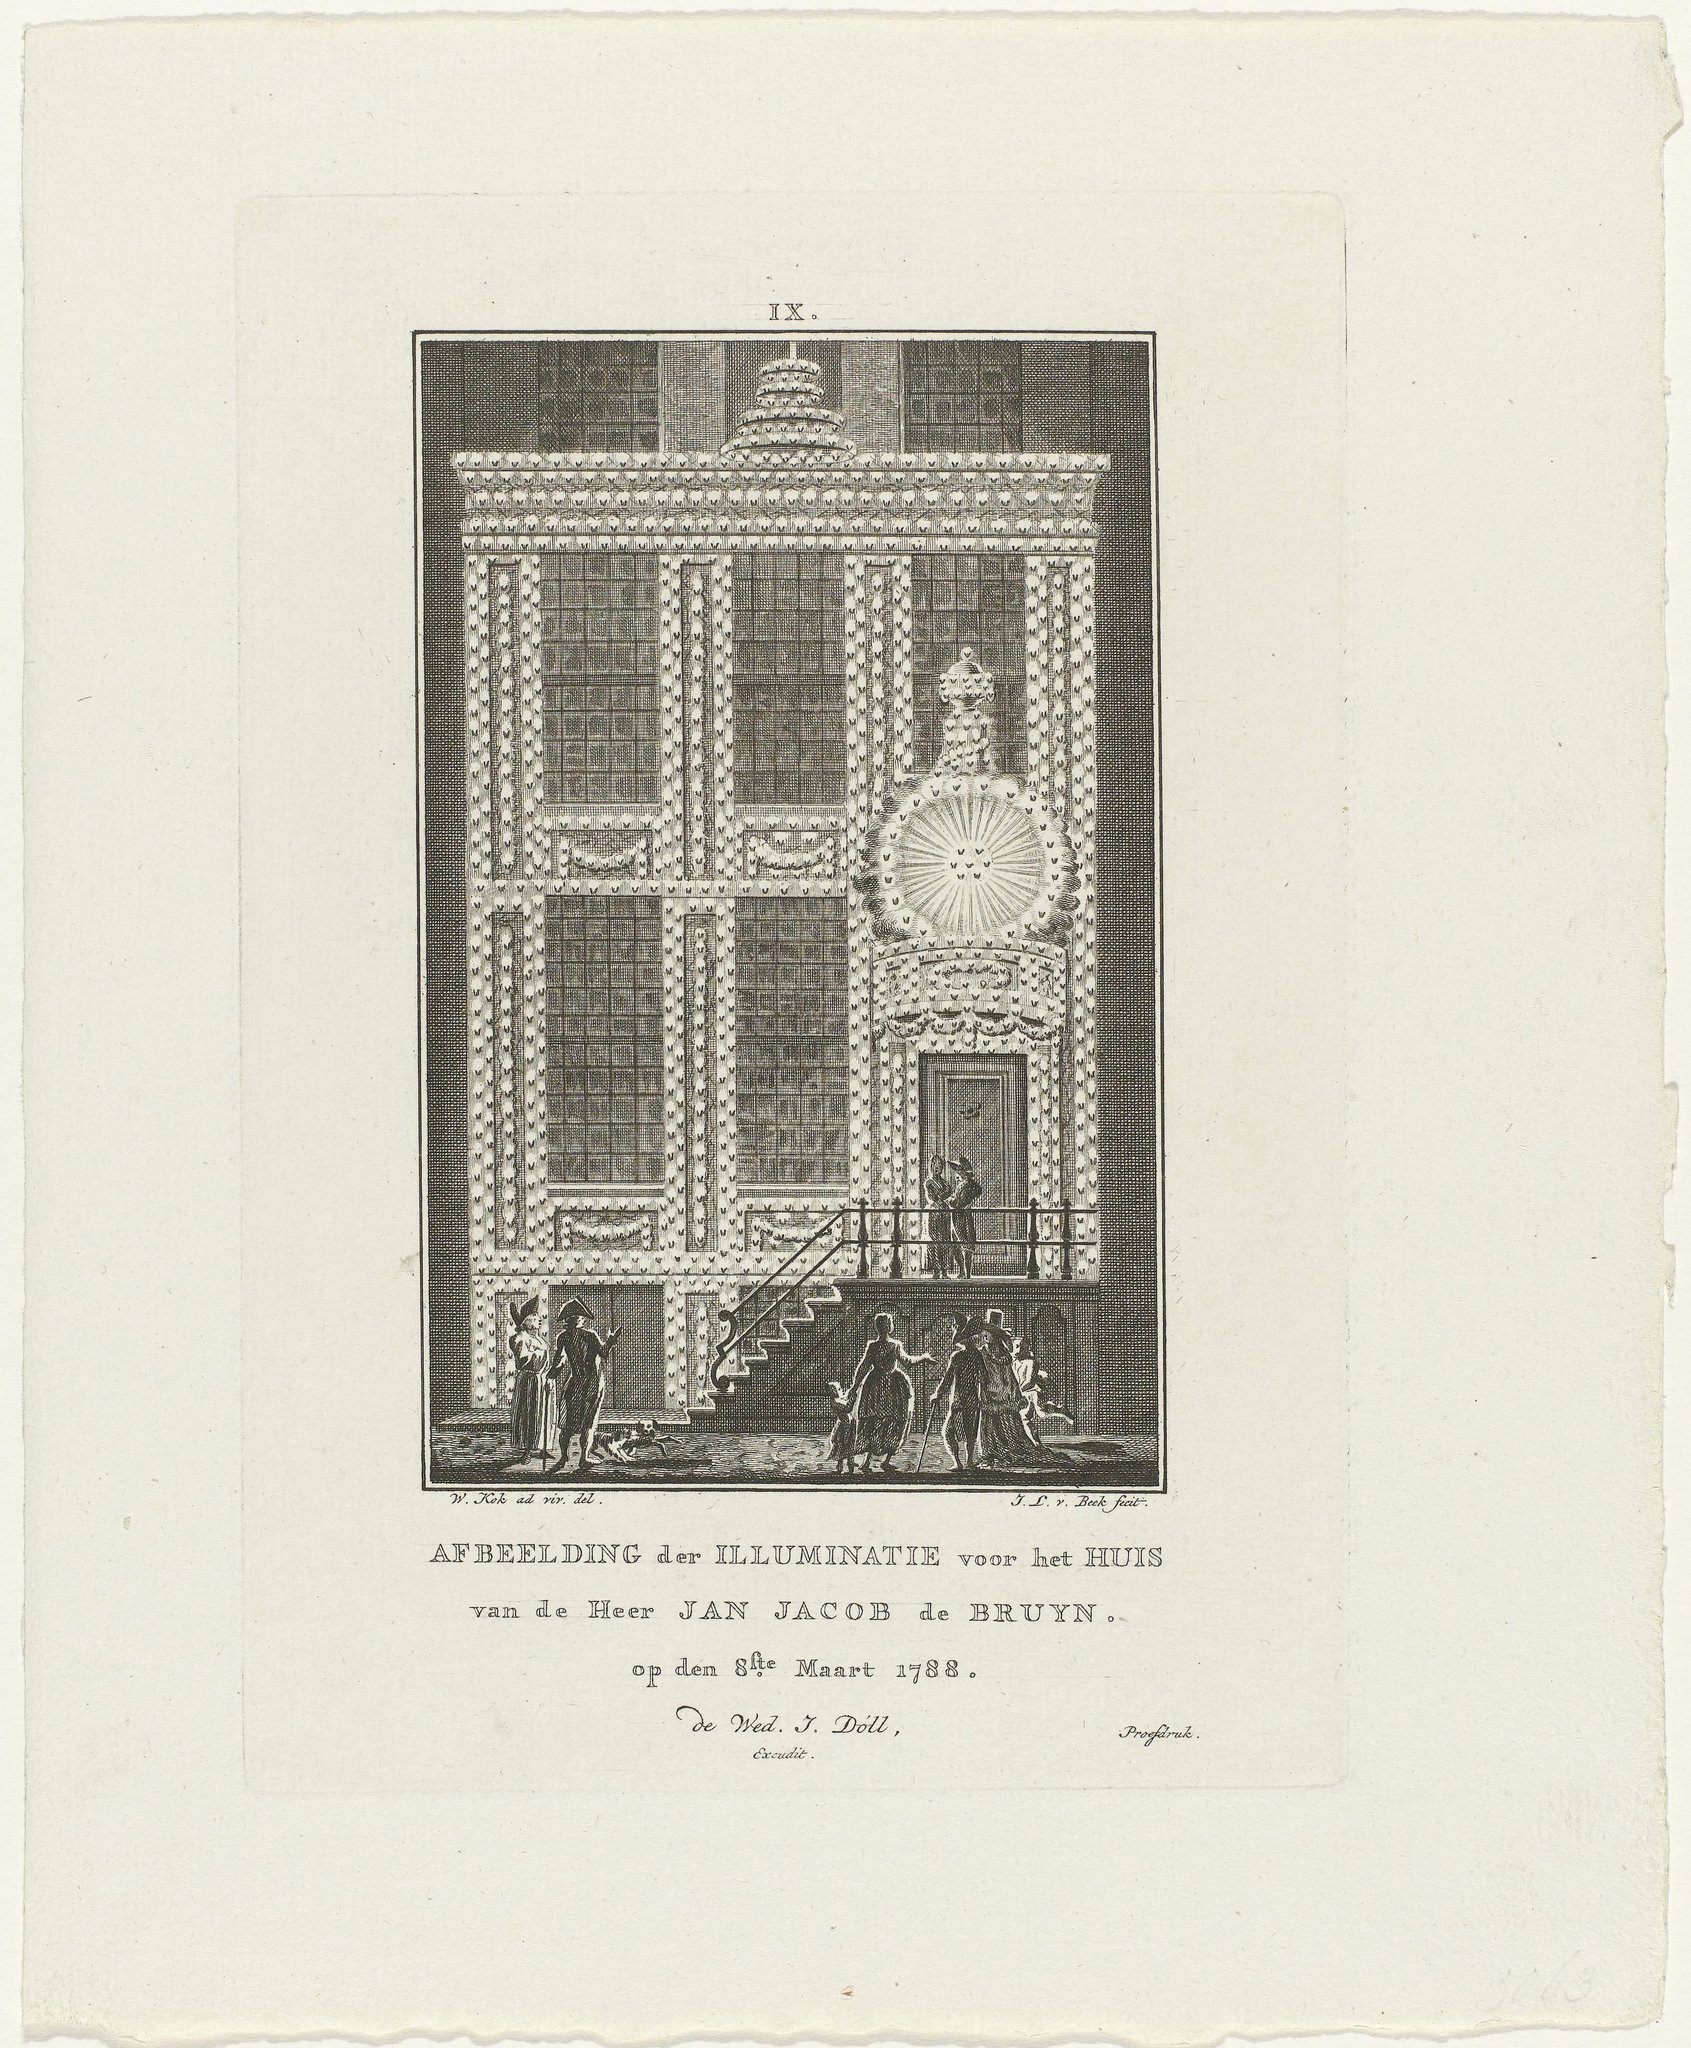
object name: print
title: Illuminatie voor het huis van Jan Jacob de Bruyn te Amsterdam, 1788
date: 1788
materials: paper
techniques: engraving, etching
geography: amsterdam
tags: william v (prince of orange), jan jacob de bruyn, bonfire, fire-works (+ illumination, fire-works ~ festive activities), amsterdam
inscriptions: collector's mark: Lugt 2228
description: Illuminatie aangebracht voor het huis van Jan Jacob de Bruyn aan de Keizersgracht te Amsterdam. Genummerd bovenaan: IX. Onderdeel van een reeks van twaalf platen van de illuminaties en decoraties te Amsterdam op de 40ste verjaardag van prins Willem V op 8 maart 1788.